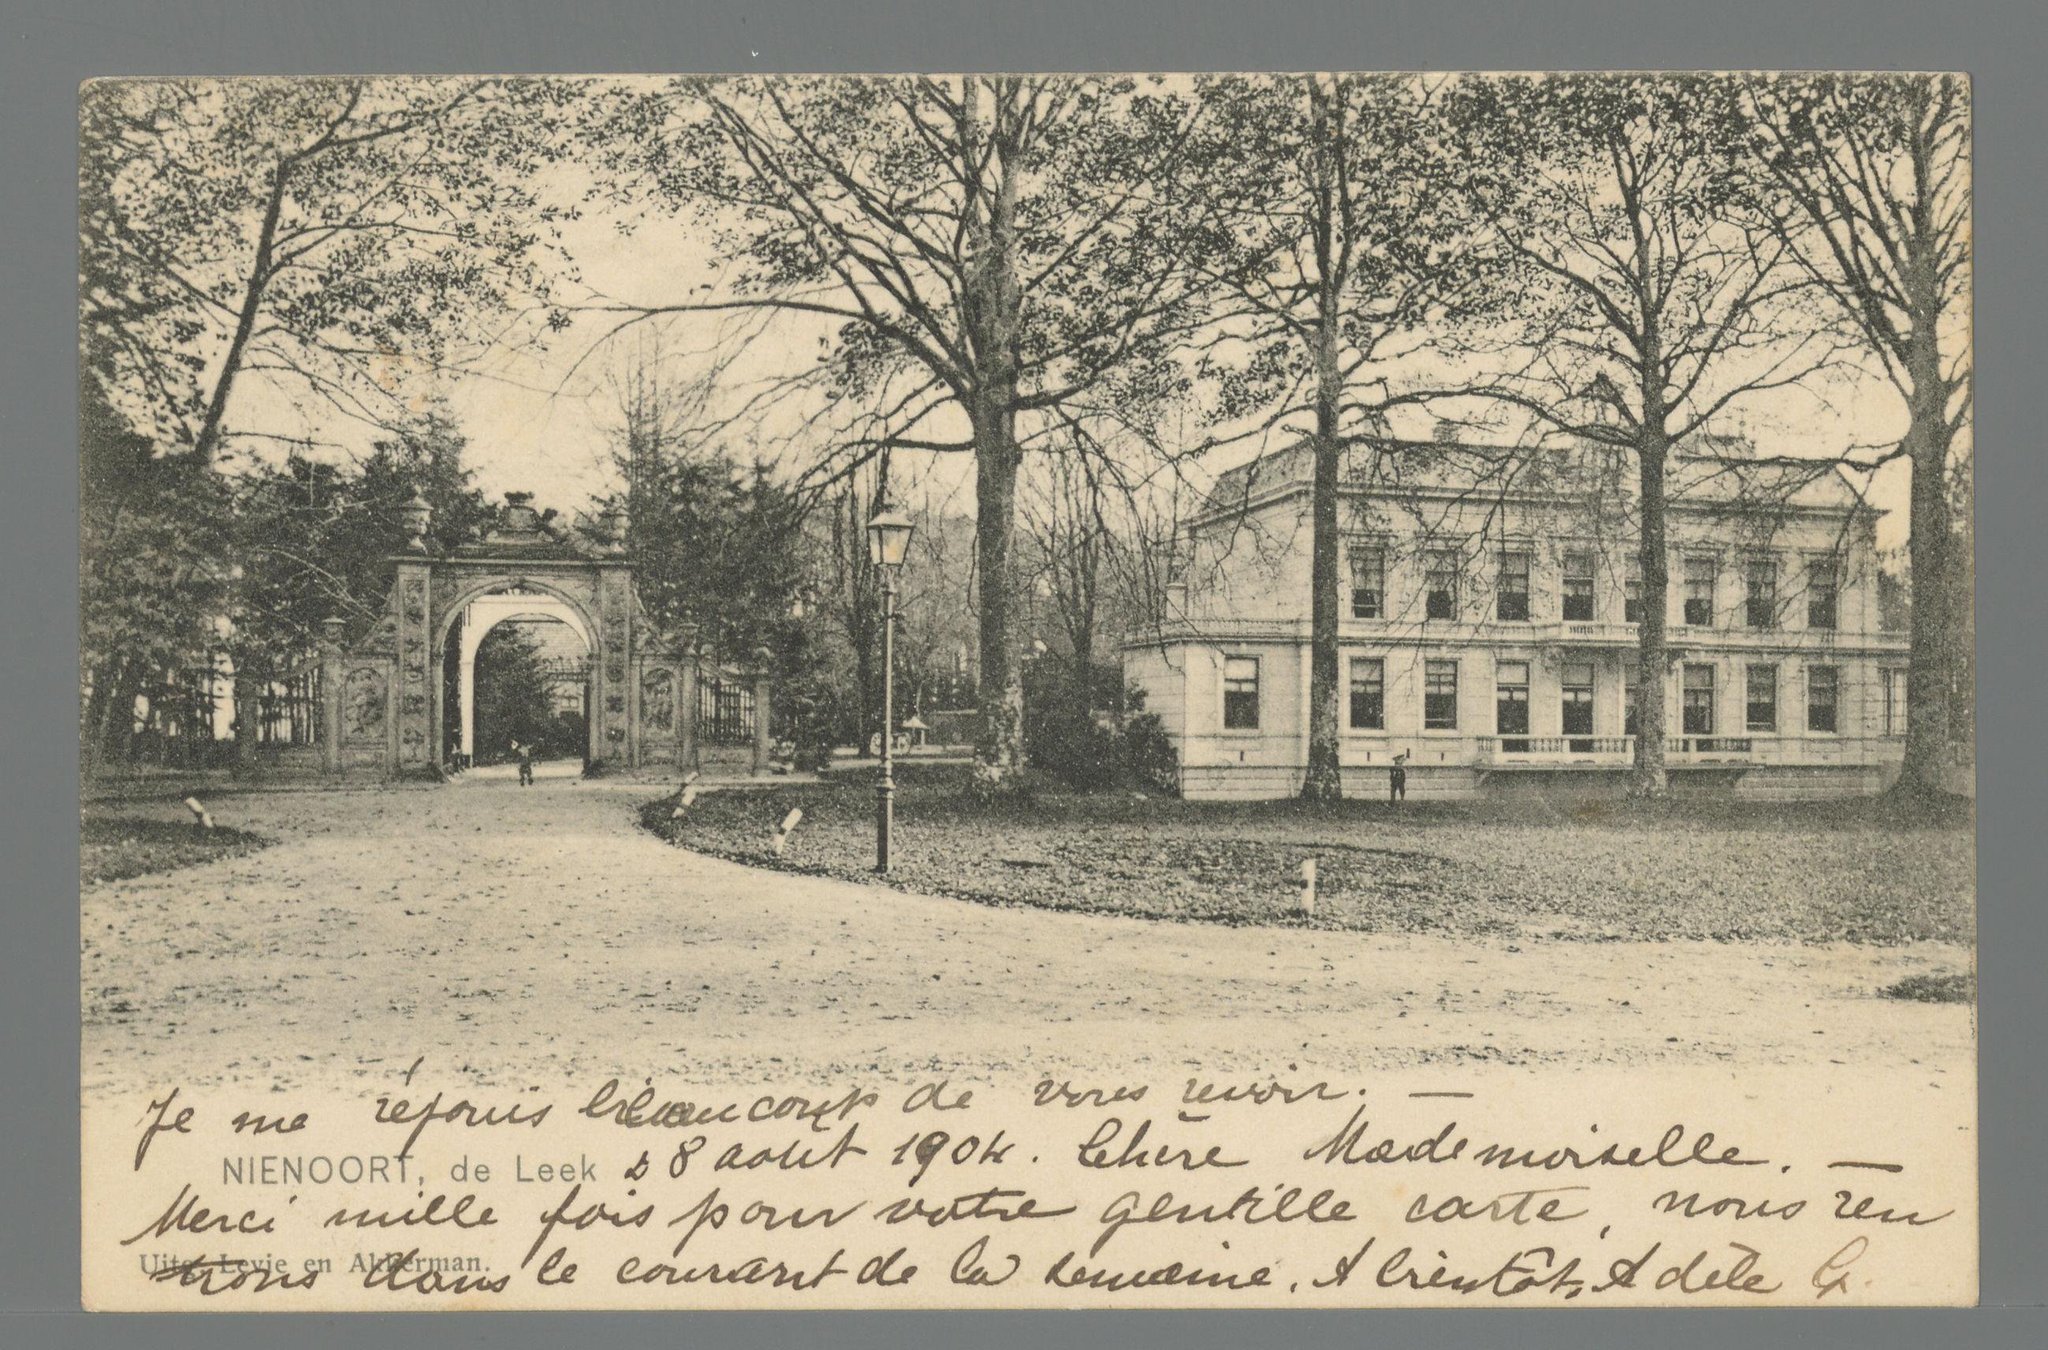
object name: ansichtkaart, prentbriefkaart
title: Nienoort, de Leek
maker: Anonymous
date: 1897-1904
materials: cardboard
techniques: photograph, writing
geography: leek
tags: gate, entrance, country-house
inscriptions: postage stamp